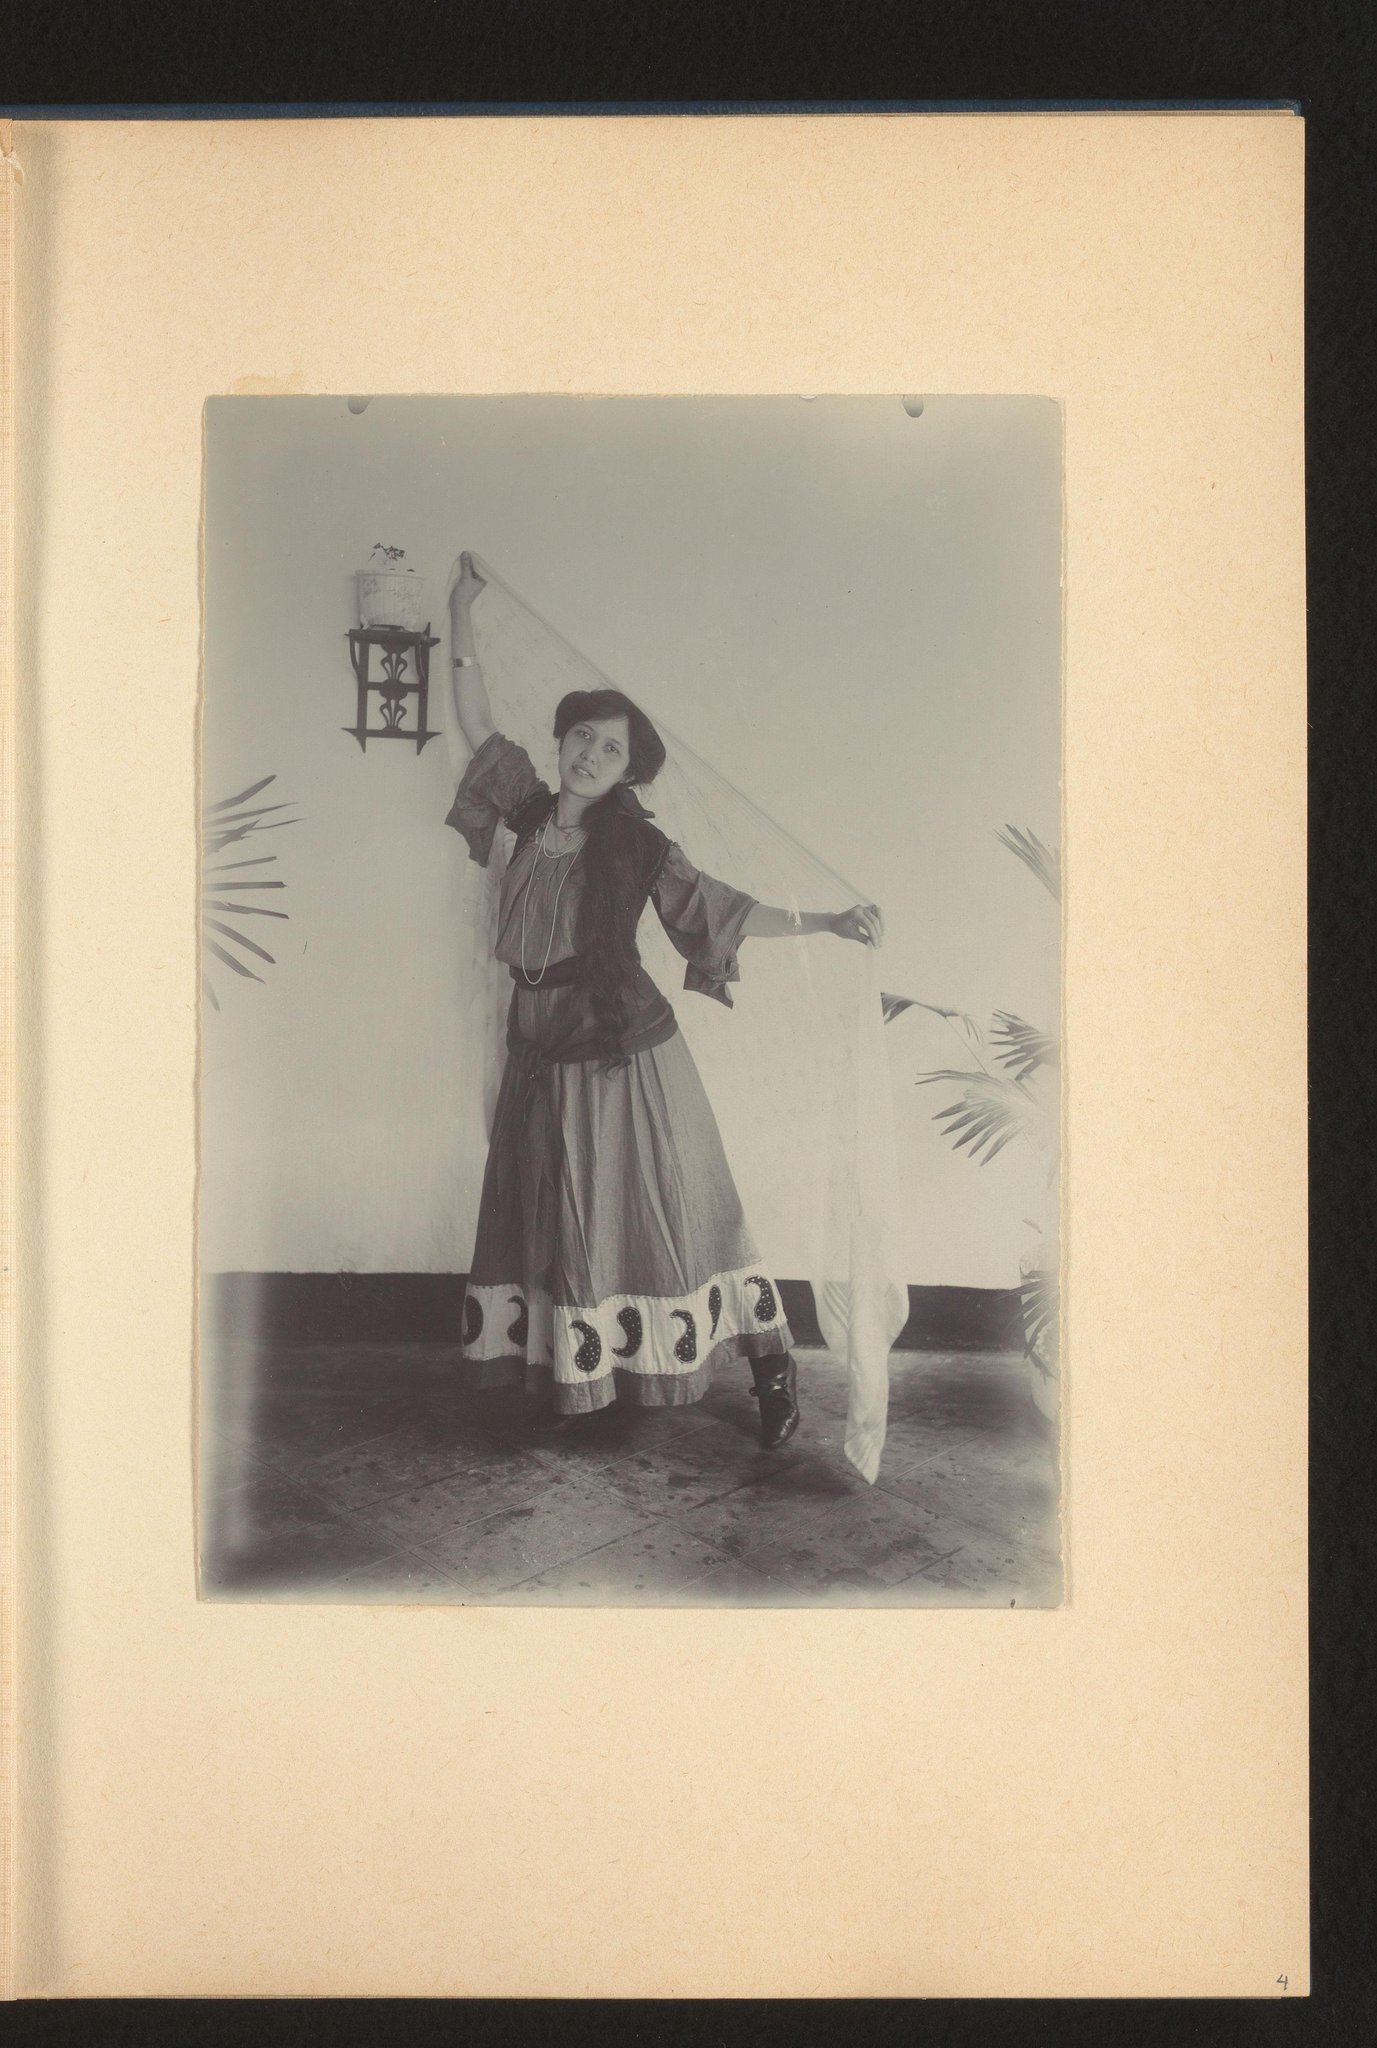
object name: album leaf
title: Moeder van Eef Dumas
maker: Anonymous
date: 1900-1910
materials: cardboard, photographic support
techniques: gelatin silver print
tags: beatrice jacqueline eveline dumas, adult woman, historical persons - bb - woman, family life at home, netherlands, dutch east indies, the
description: Blad met een foto van Augustine Pauline Bruins, de moeder van Eef Dumas. Jonge vrouw staande met een sluier die ze boven haar hoofd houdt. Onderdeel van het fotoalbum van Beatrice Jacqueline Eveline (Eef) Dumas, ca. 1880-1952.